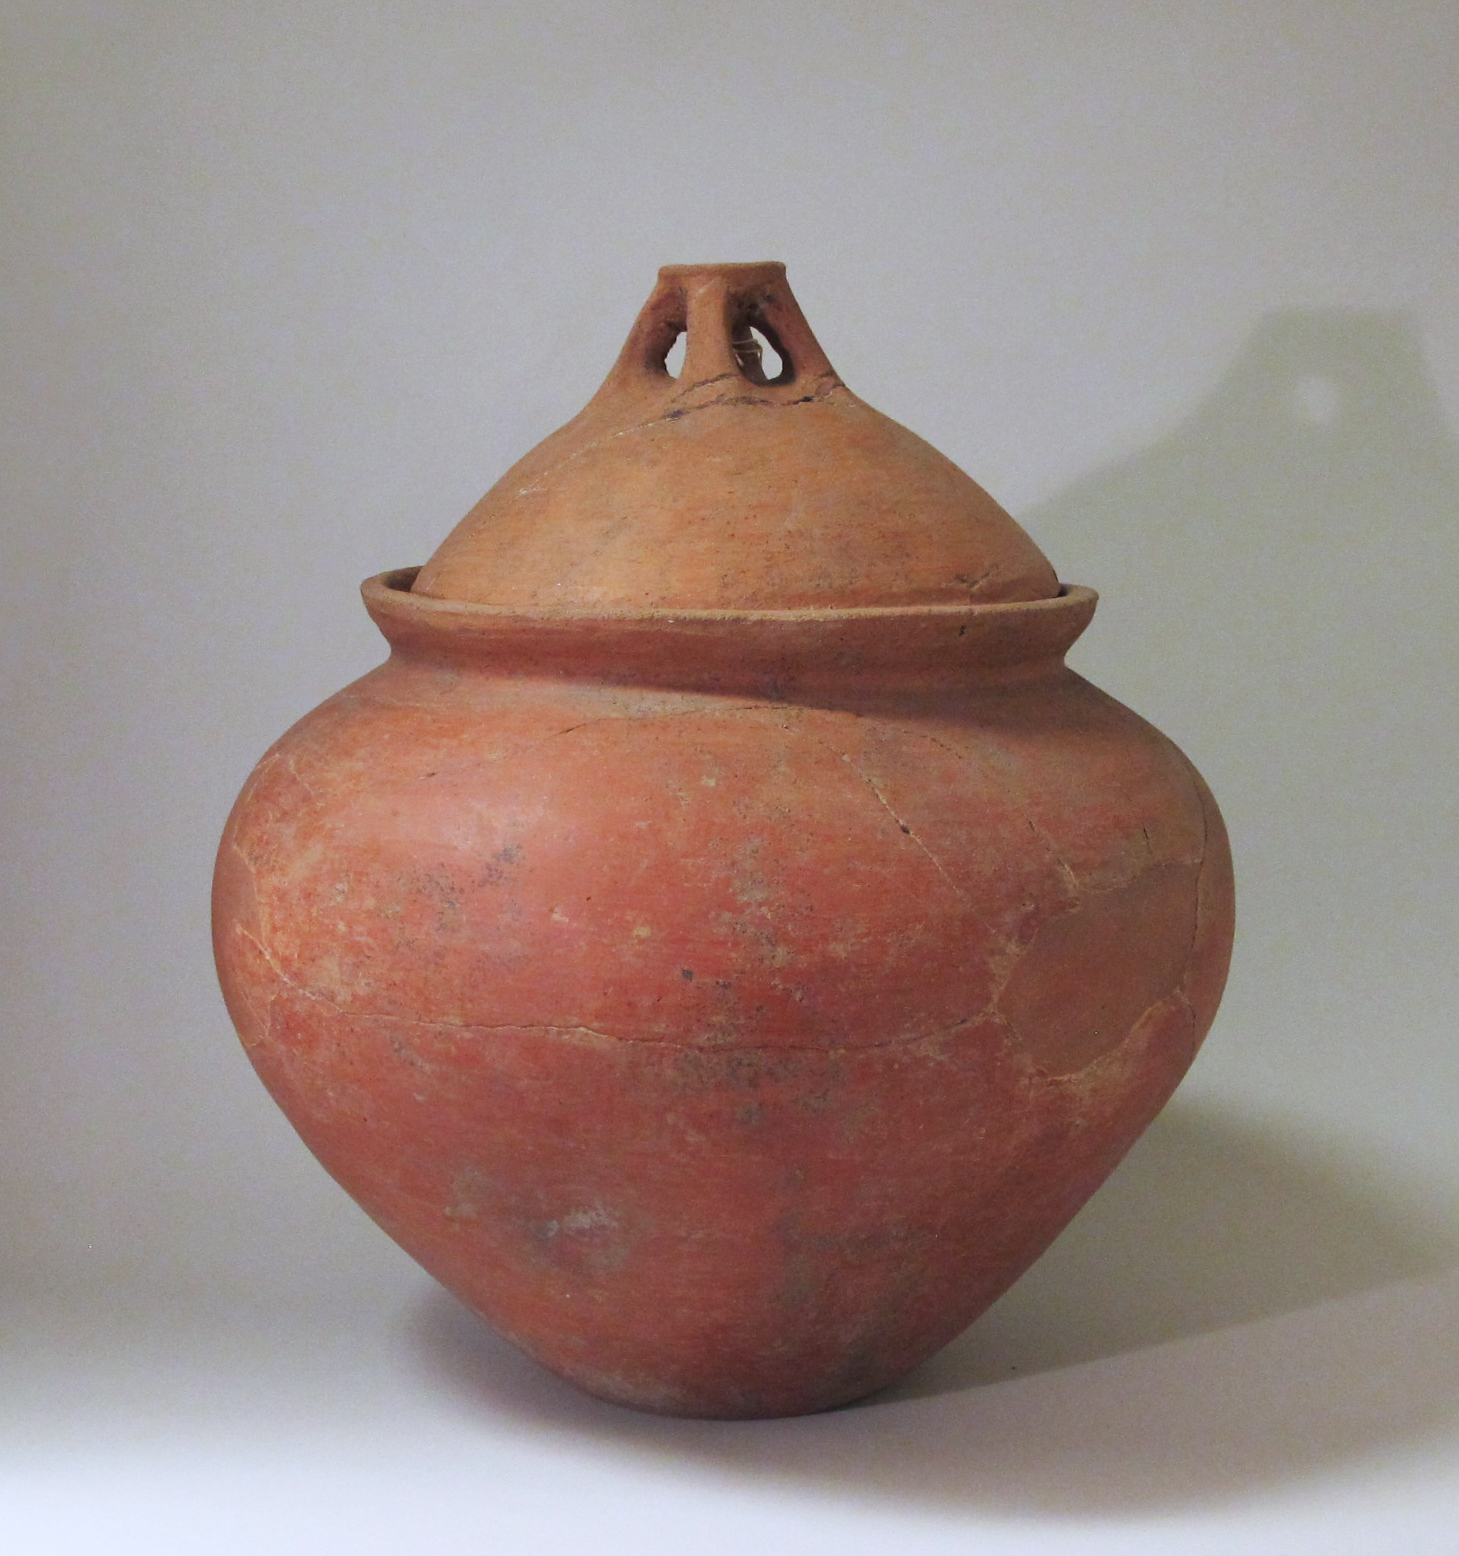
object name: jar with lid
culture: etruscan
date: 700-601 BCE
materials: terracotta